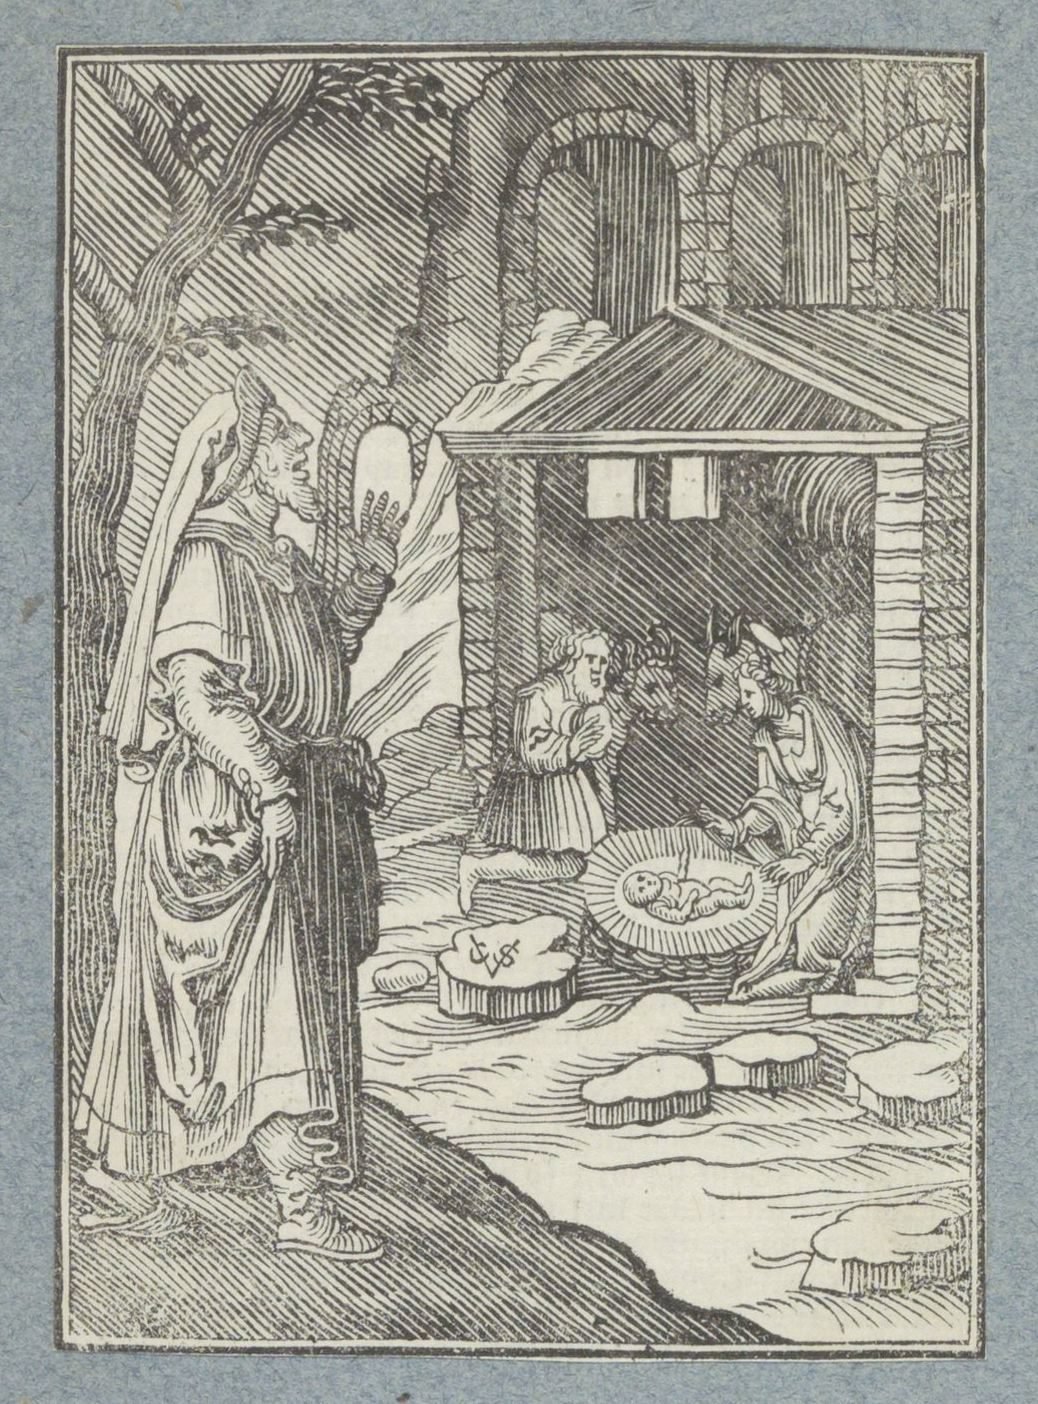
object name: print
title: Profetie van Micha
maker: pieter jacobsz. paets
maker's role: publisher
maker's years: 1587-1667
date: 1645-1646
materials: paper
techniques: woodcut, pasting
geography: amsterdam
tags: micah's prophecy concerning bethlehem (micah 5:2)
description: De prent werd gemaakt voor de uitgaven van P.J. Paets uit Amsterdam. Ze komt in ieder geval voor in: Bibels Tresoor ofte der zielen lusthof. Amsterdam, P.J. Paets, 1646. Mogelijk ook in: Historien ende Prophetien. [Amsterdam], P.J. Paets, 1645.